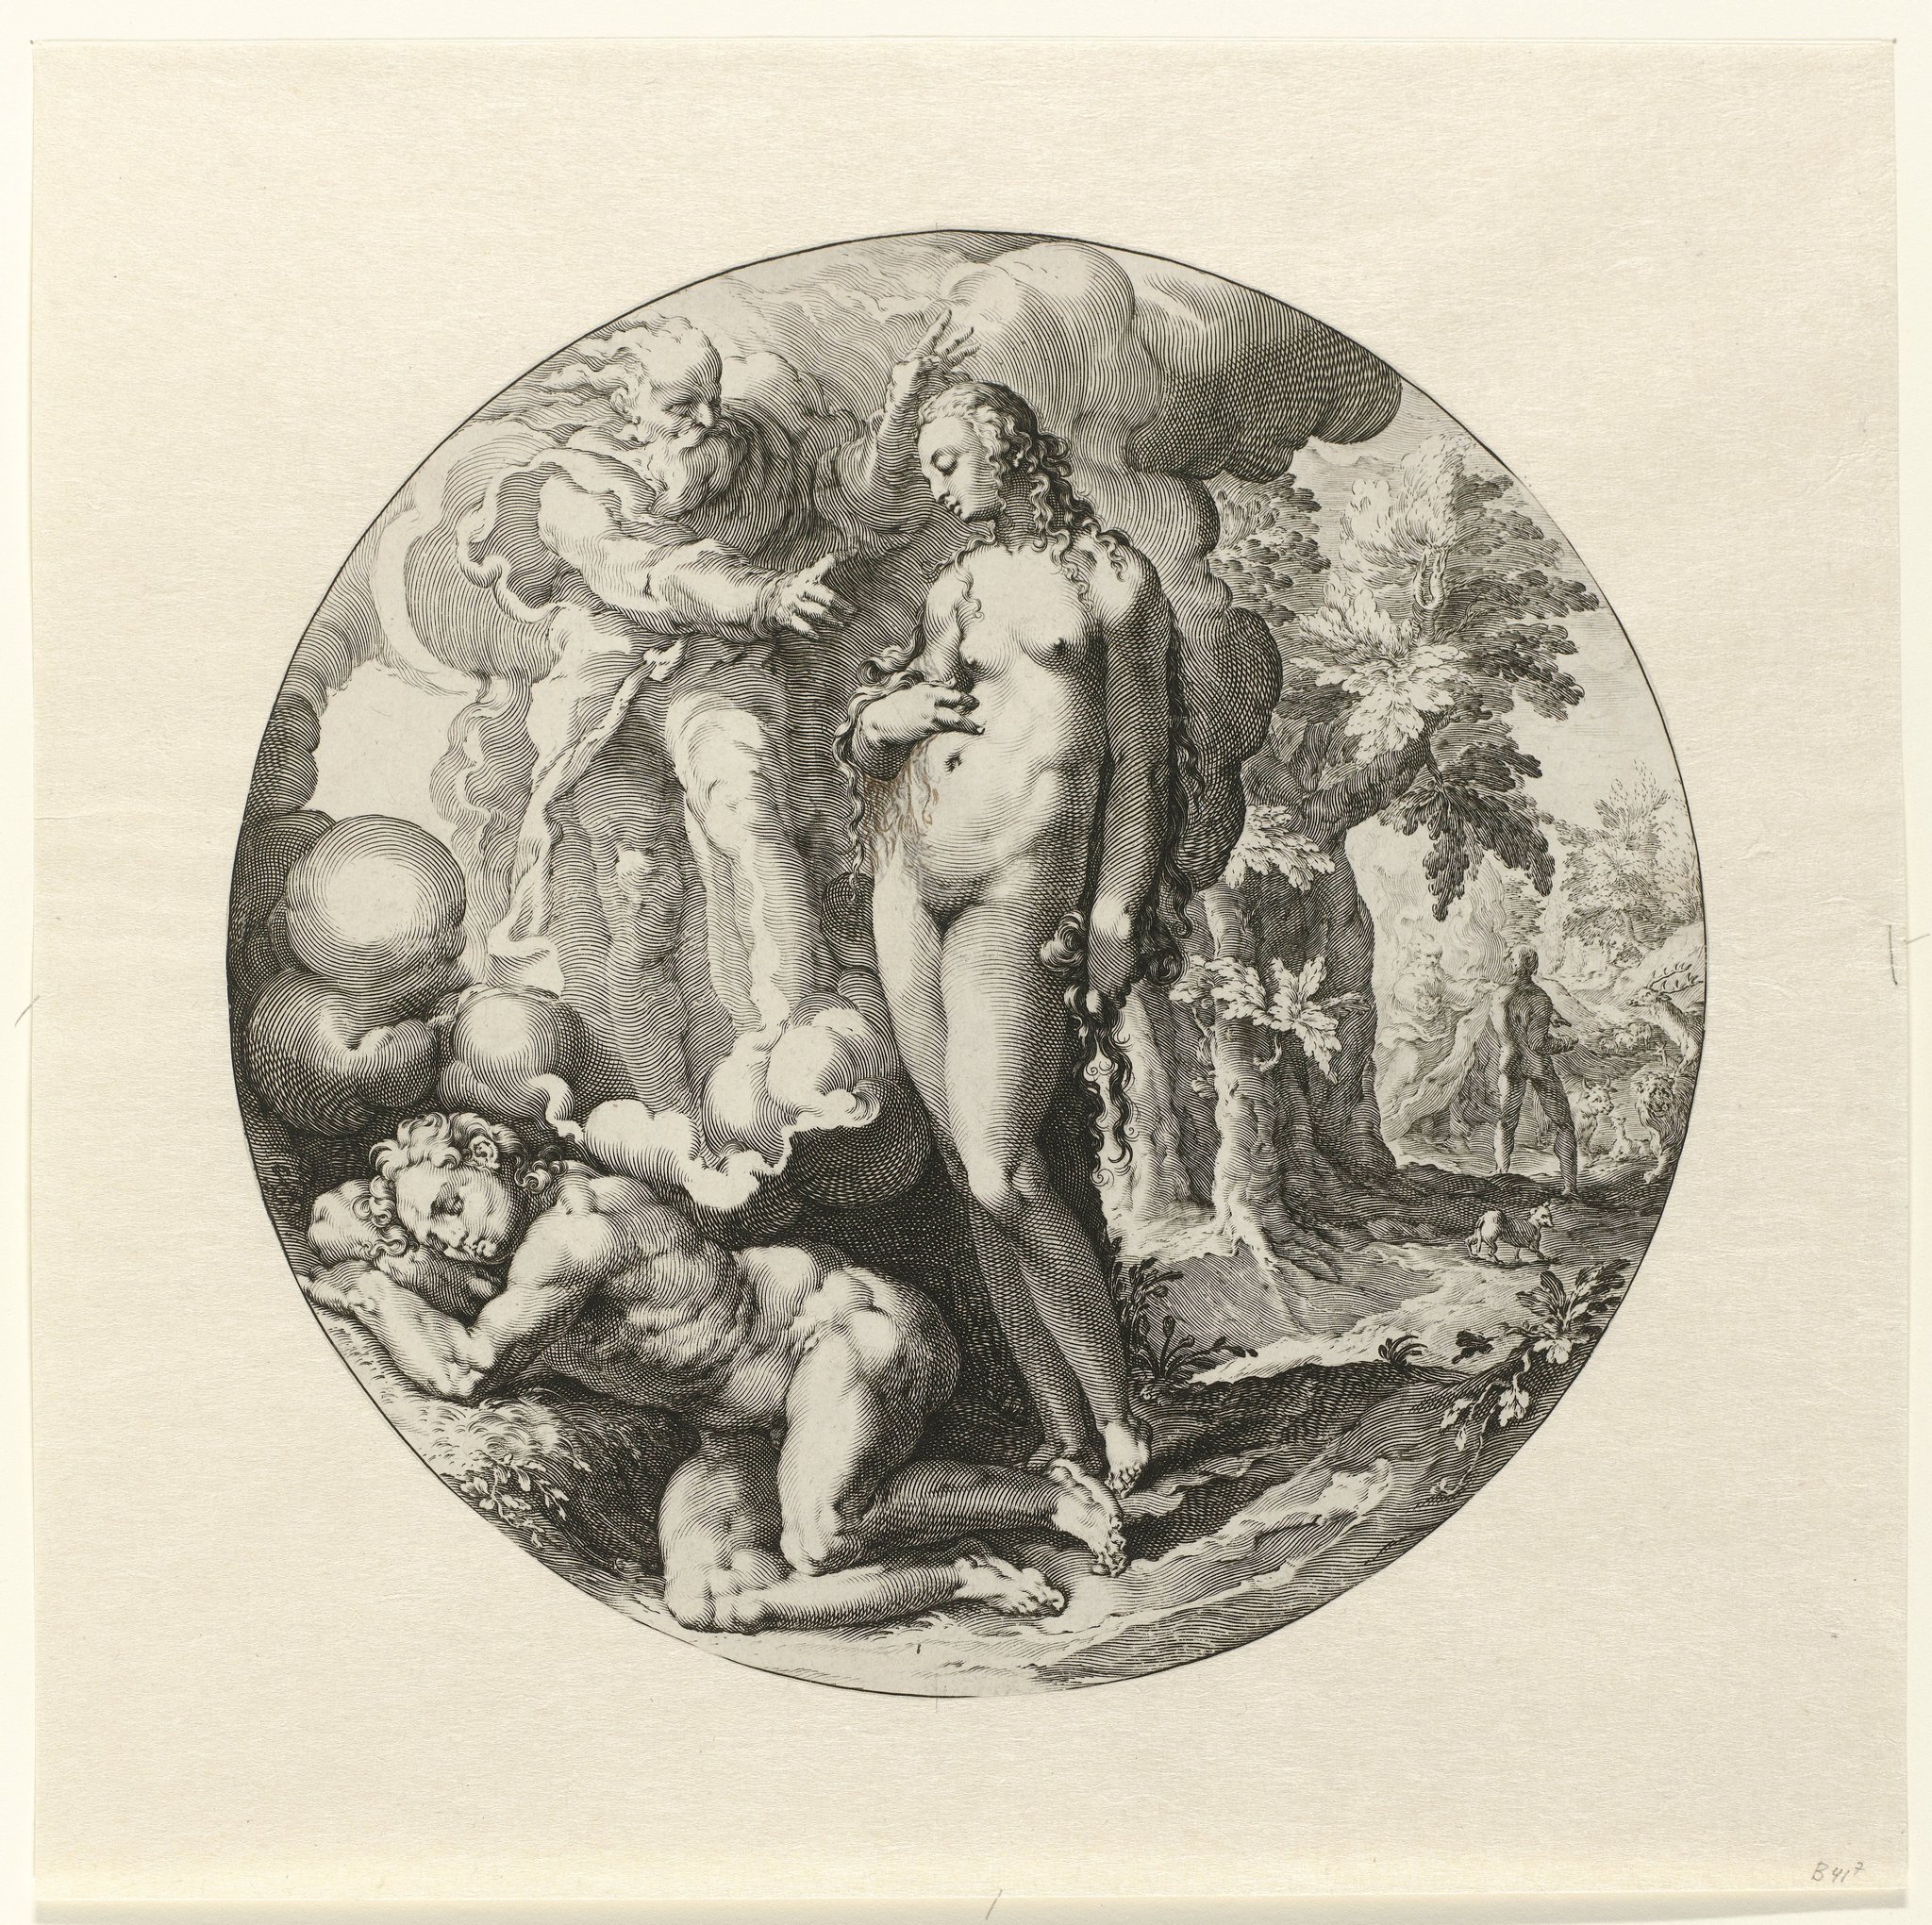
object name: print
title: De schepping van de wereld: schepping van de mens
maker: jan harmensz. muller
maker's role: draughtsman, print maker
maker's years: 1571-1628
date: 1581-1628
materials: paper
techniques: engraving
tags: creation of eve